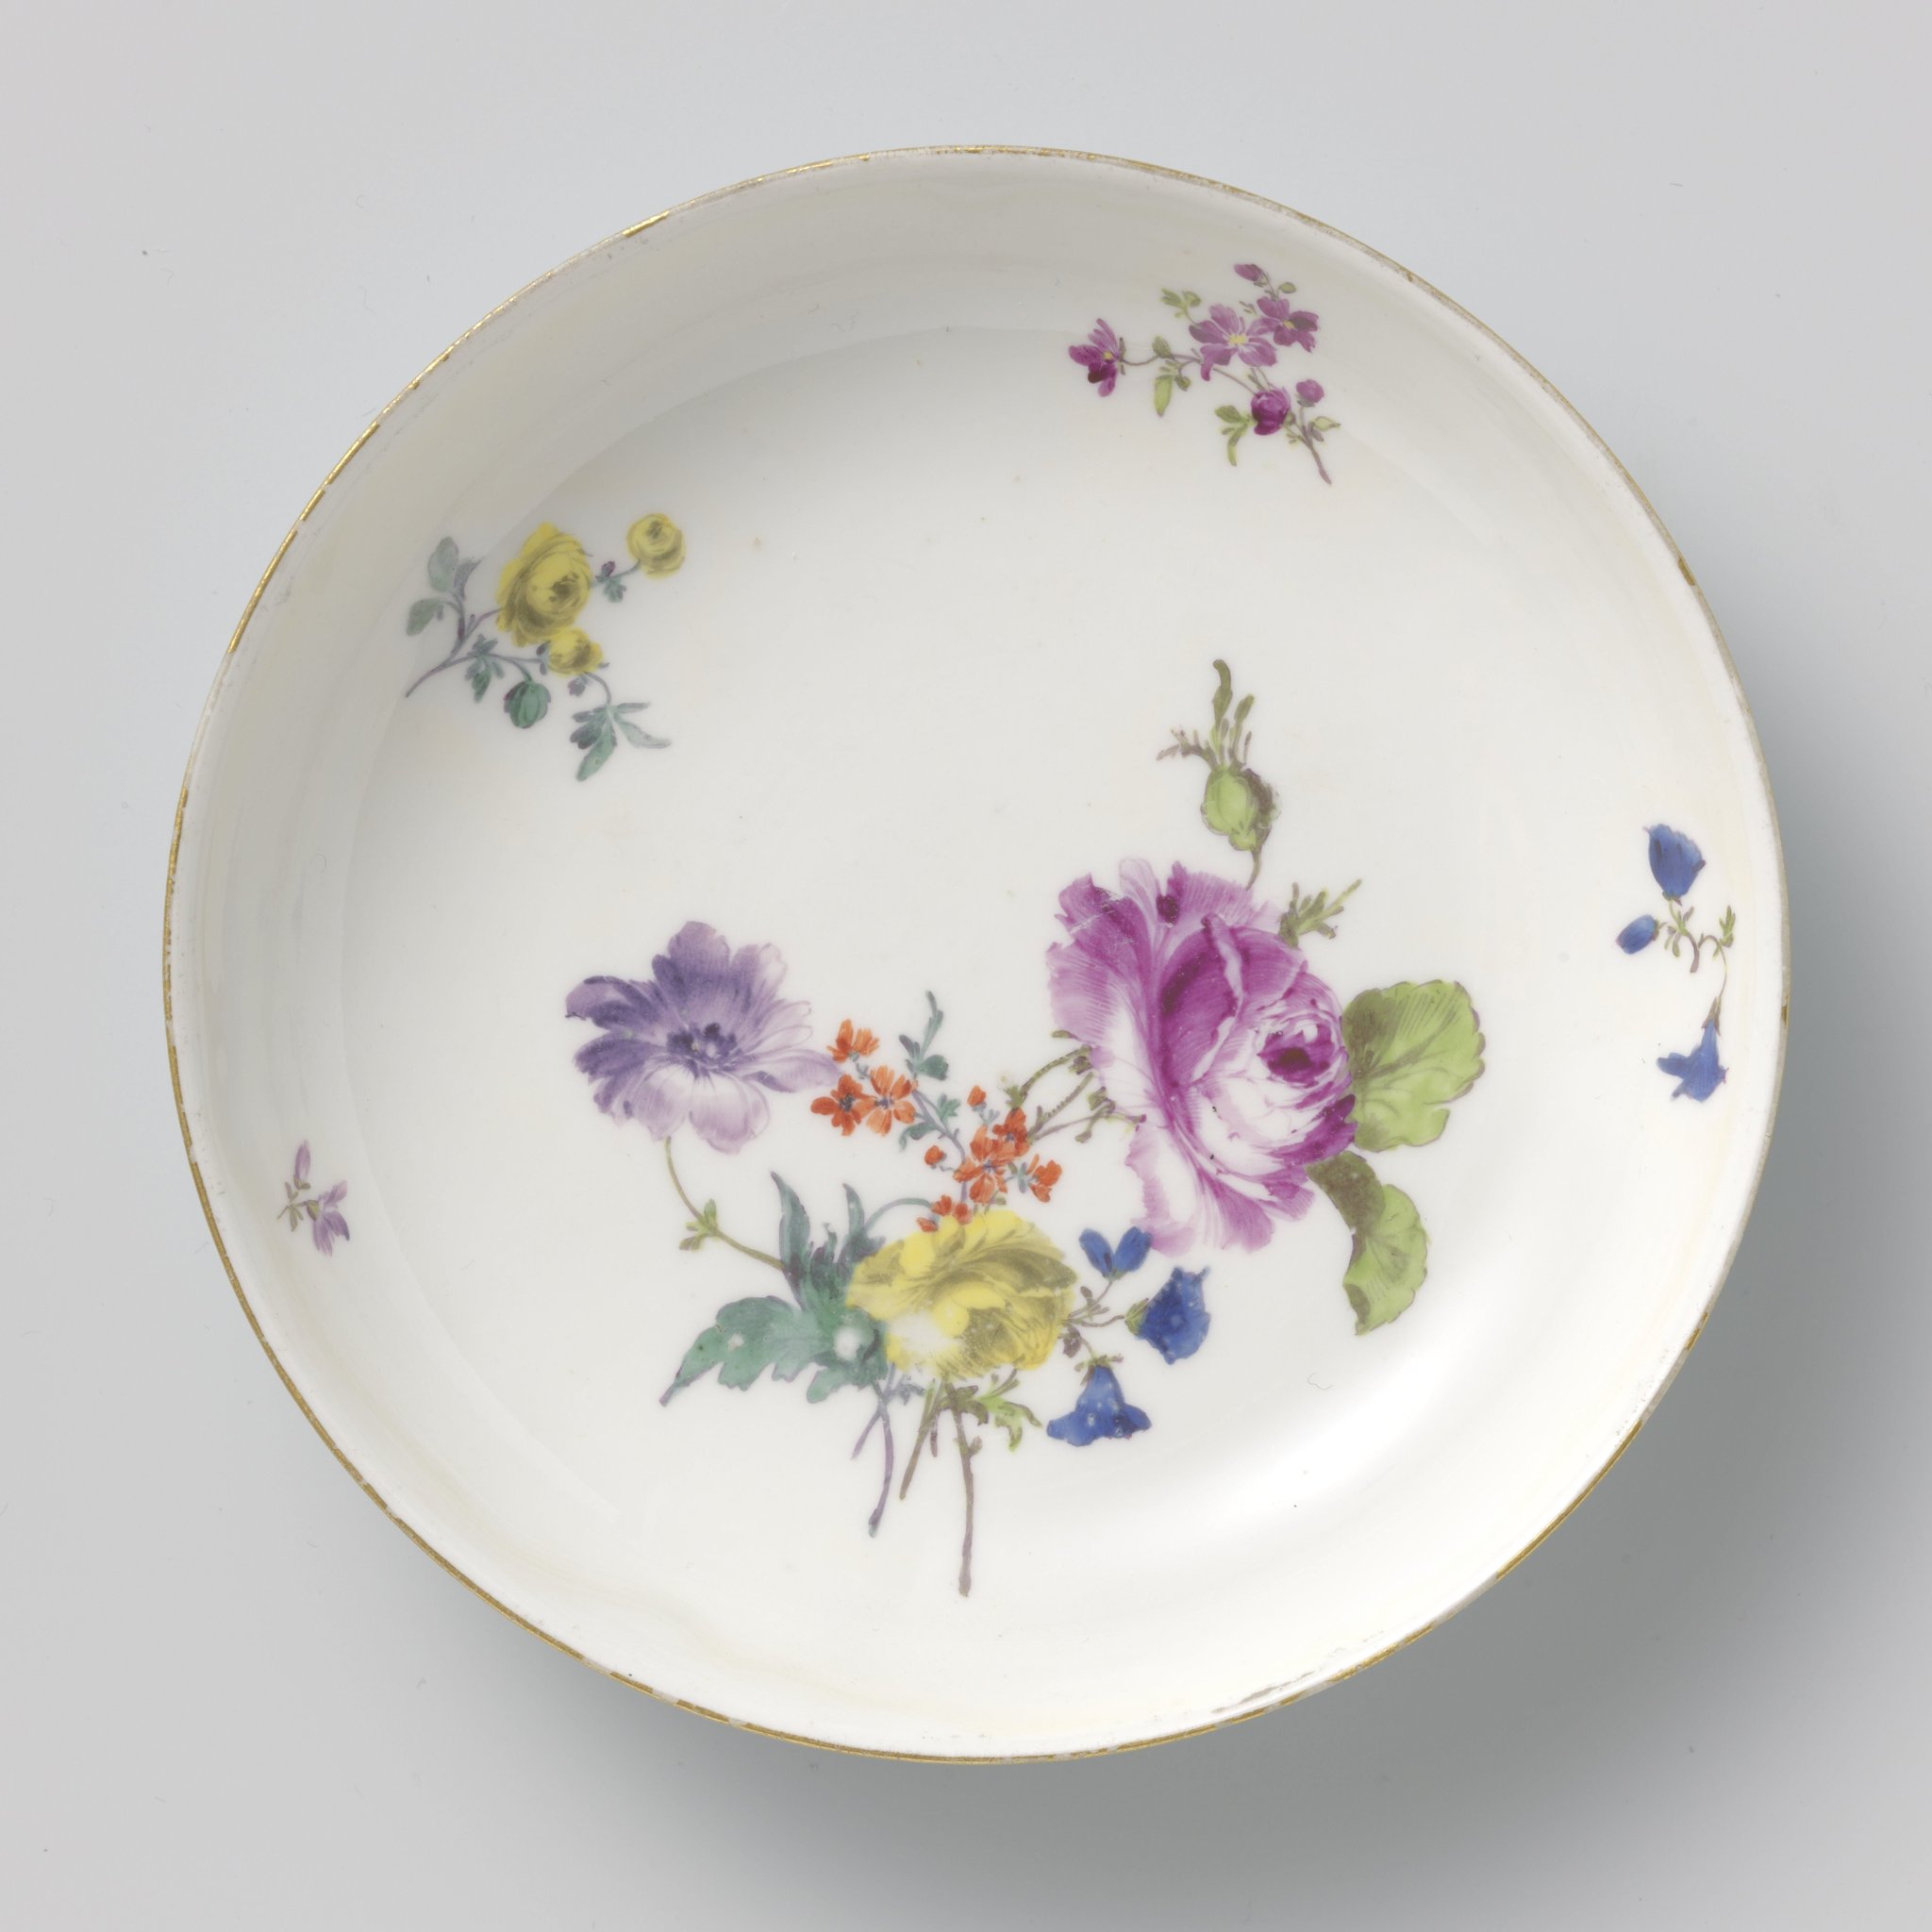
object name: platter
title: Schotel, veelkleurig beschilderd met bloemboeketten en strooibloemen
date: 1750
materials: porcelain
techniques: painted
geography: meissen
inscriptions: factory mark, mark: ‘33’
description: Schotel van beschilderd porselein. De ronde schotel is beschilderd met veelkleurige bloemboeketten en de achterkant is bedekt met een turkooise fond. De schotel is gemerkt.